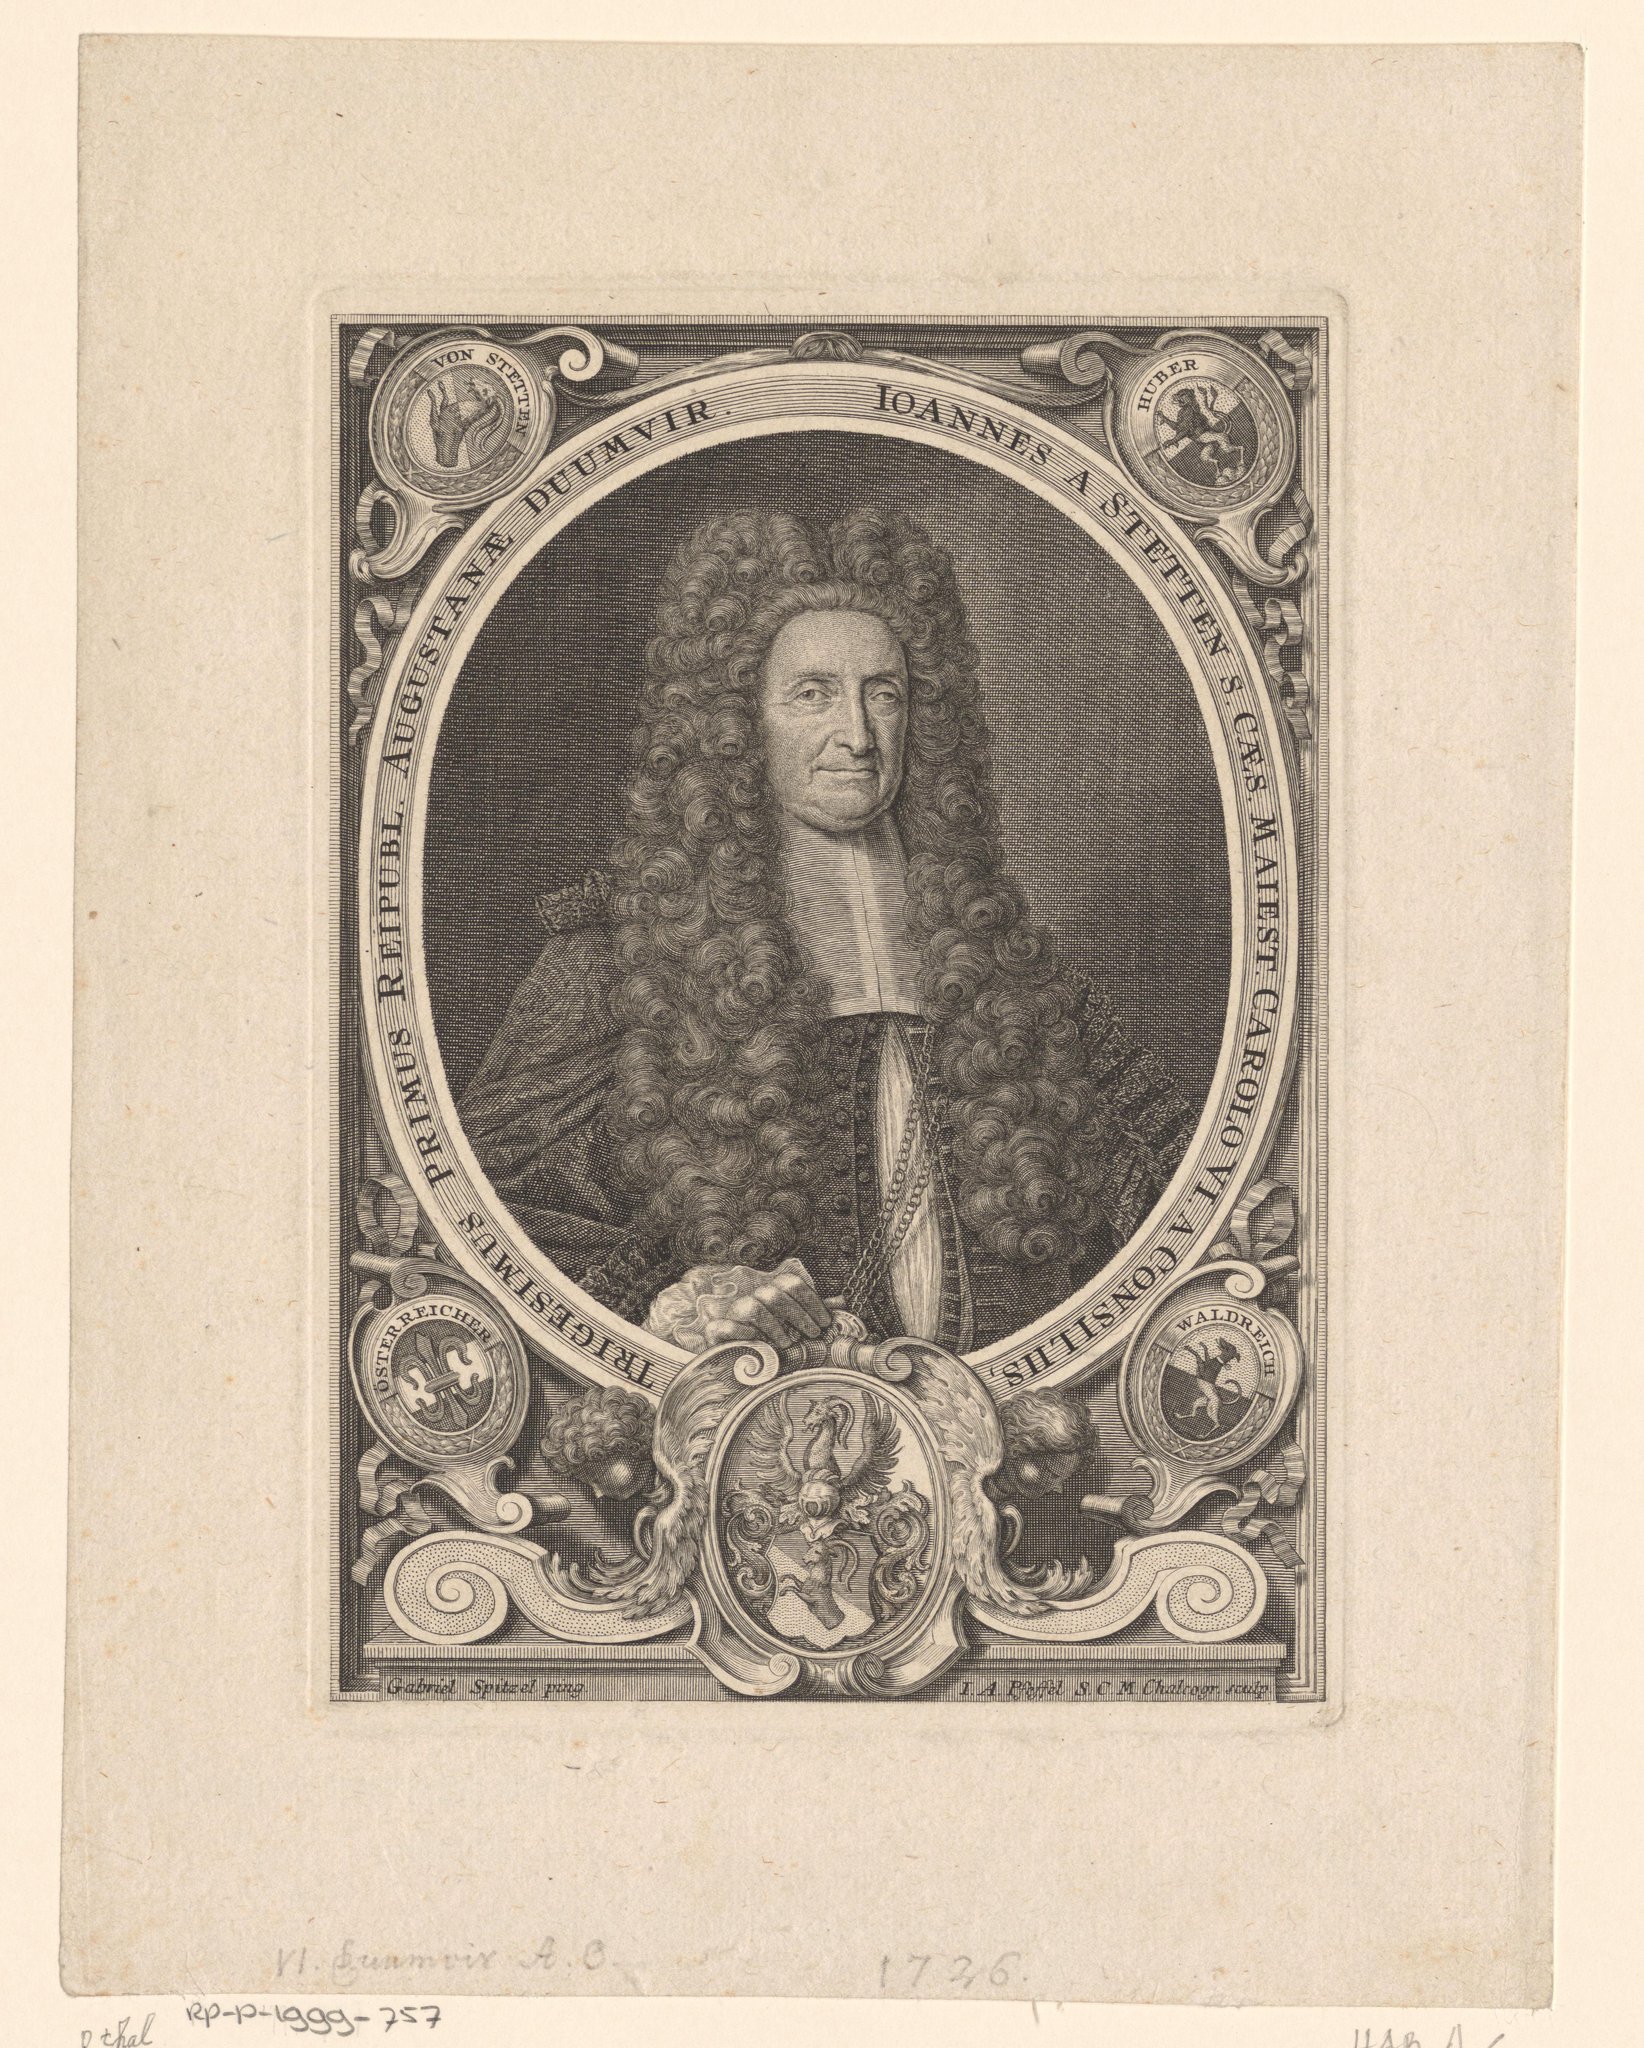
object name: print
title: Portret van Johan von Stetten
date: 1698-1748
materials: paper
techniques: engraving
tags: mayor, burgomaster, historical persons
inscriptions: collector's mark: Lugt 2228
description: Prent mogelijk uit: Cunterfait des H. Röm. Reichs Statt Augspurg seith Anno 1542 gewesten Haüpter oder Pflegern. Augsburg: s.n., 1657. Datering waarschijnlijk foutief op titelpagina in verband met werkzame periode prentmaker (1684-1748).